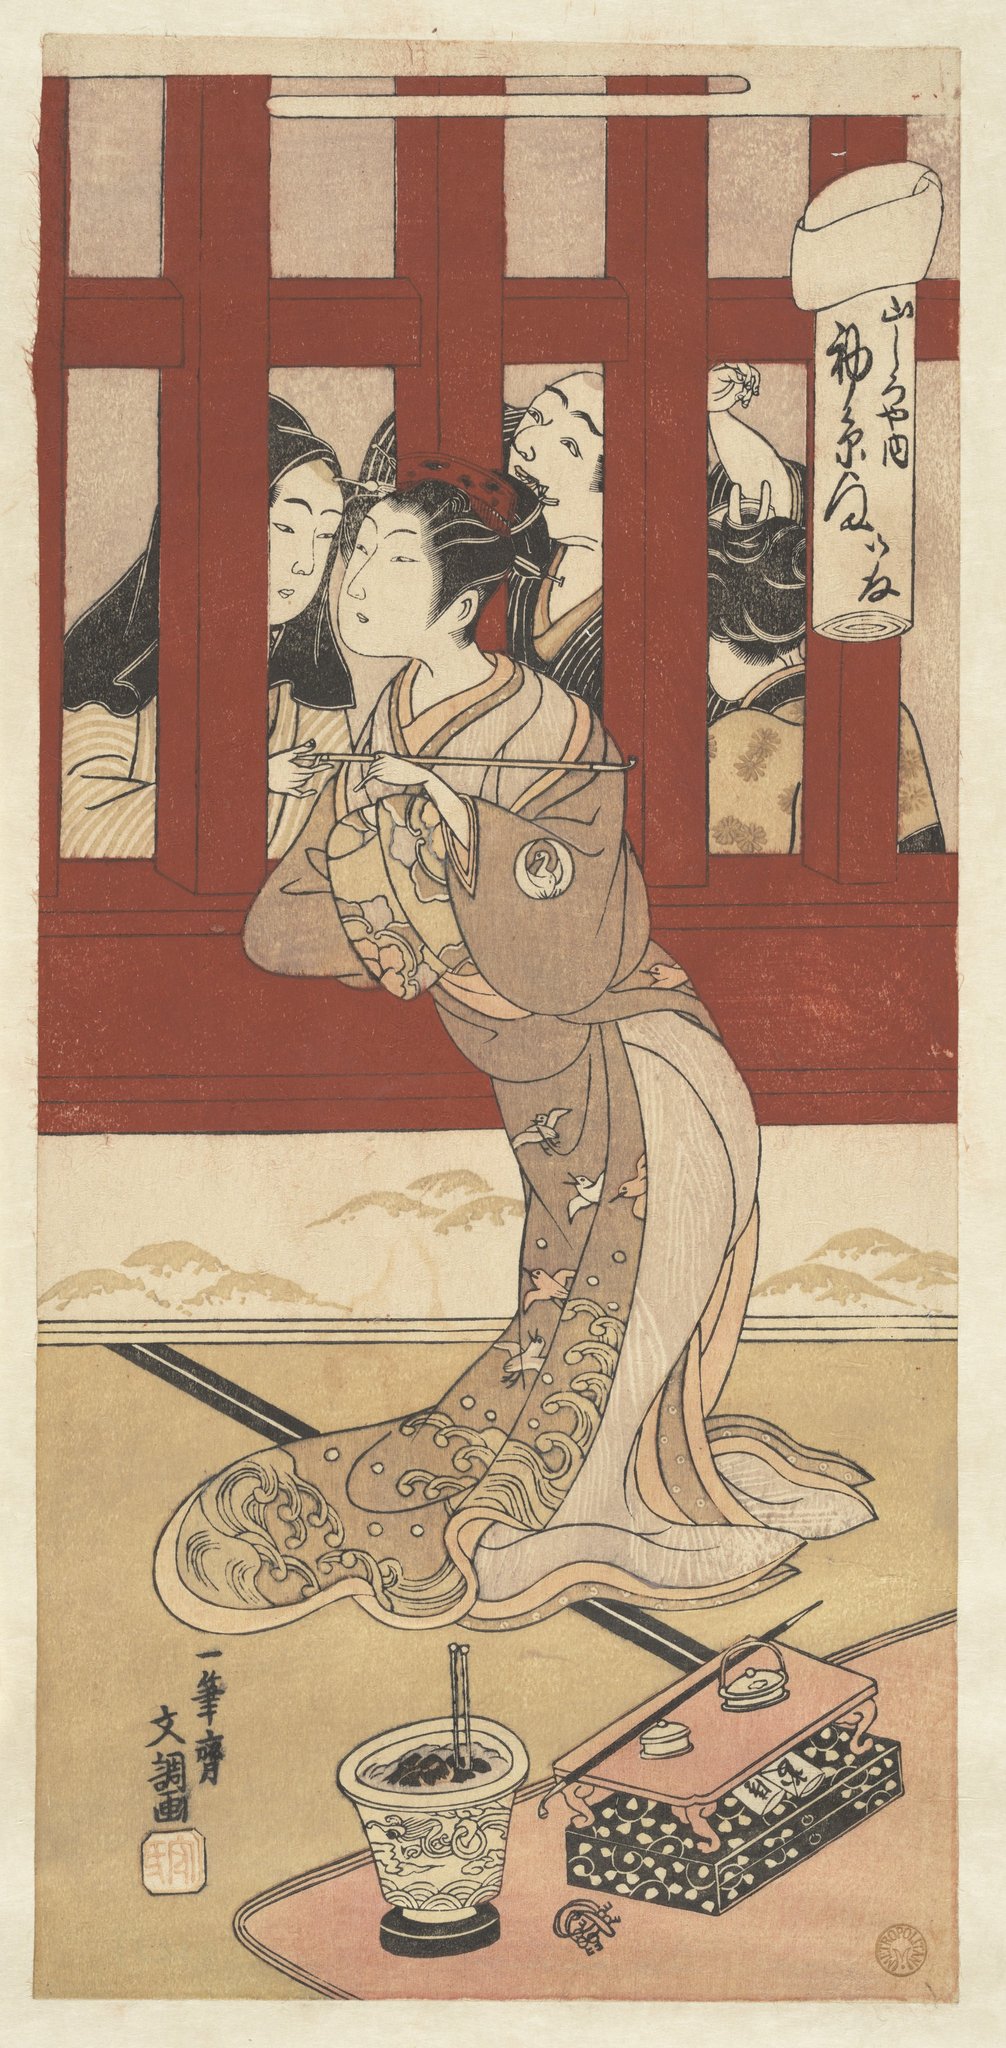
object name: print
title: The Actor Bando Hikosaburo II in the Role of the Oiran Hatsuito of Yamashiro-ya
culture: japanese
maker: ippitsusai bunchō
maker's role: artist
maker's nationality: japanese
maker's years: 1765-1792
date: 1770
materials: ink, paper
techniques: woodblock print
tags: women,actors